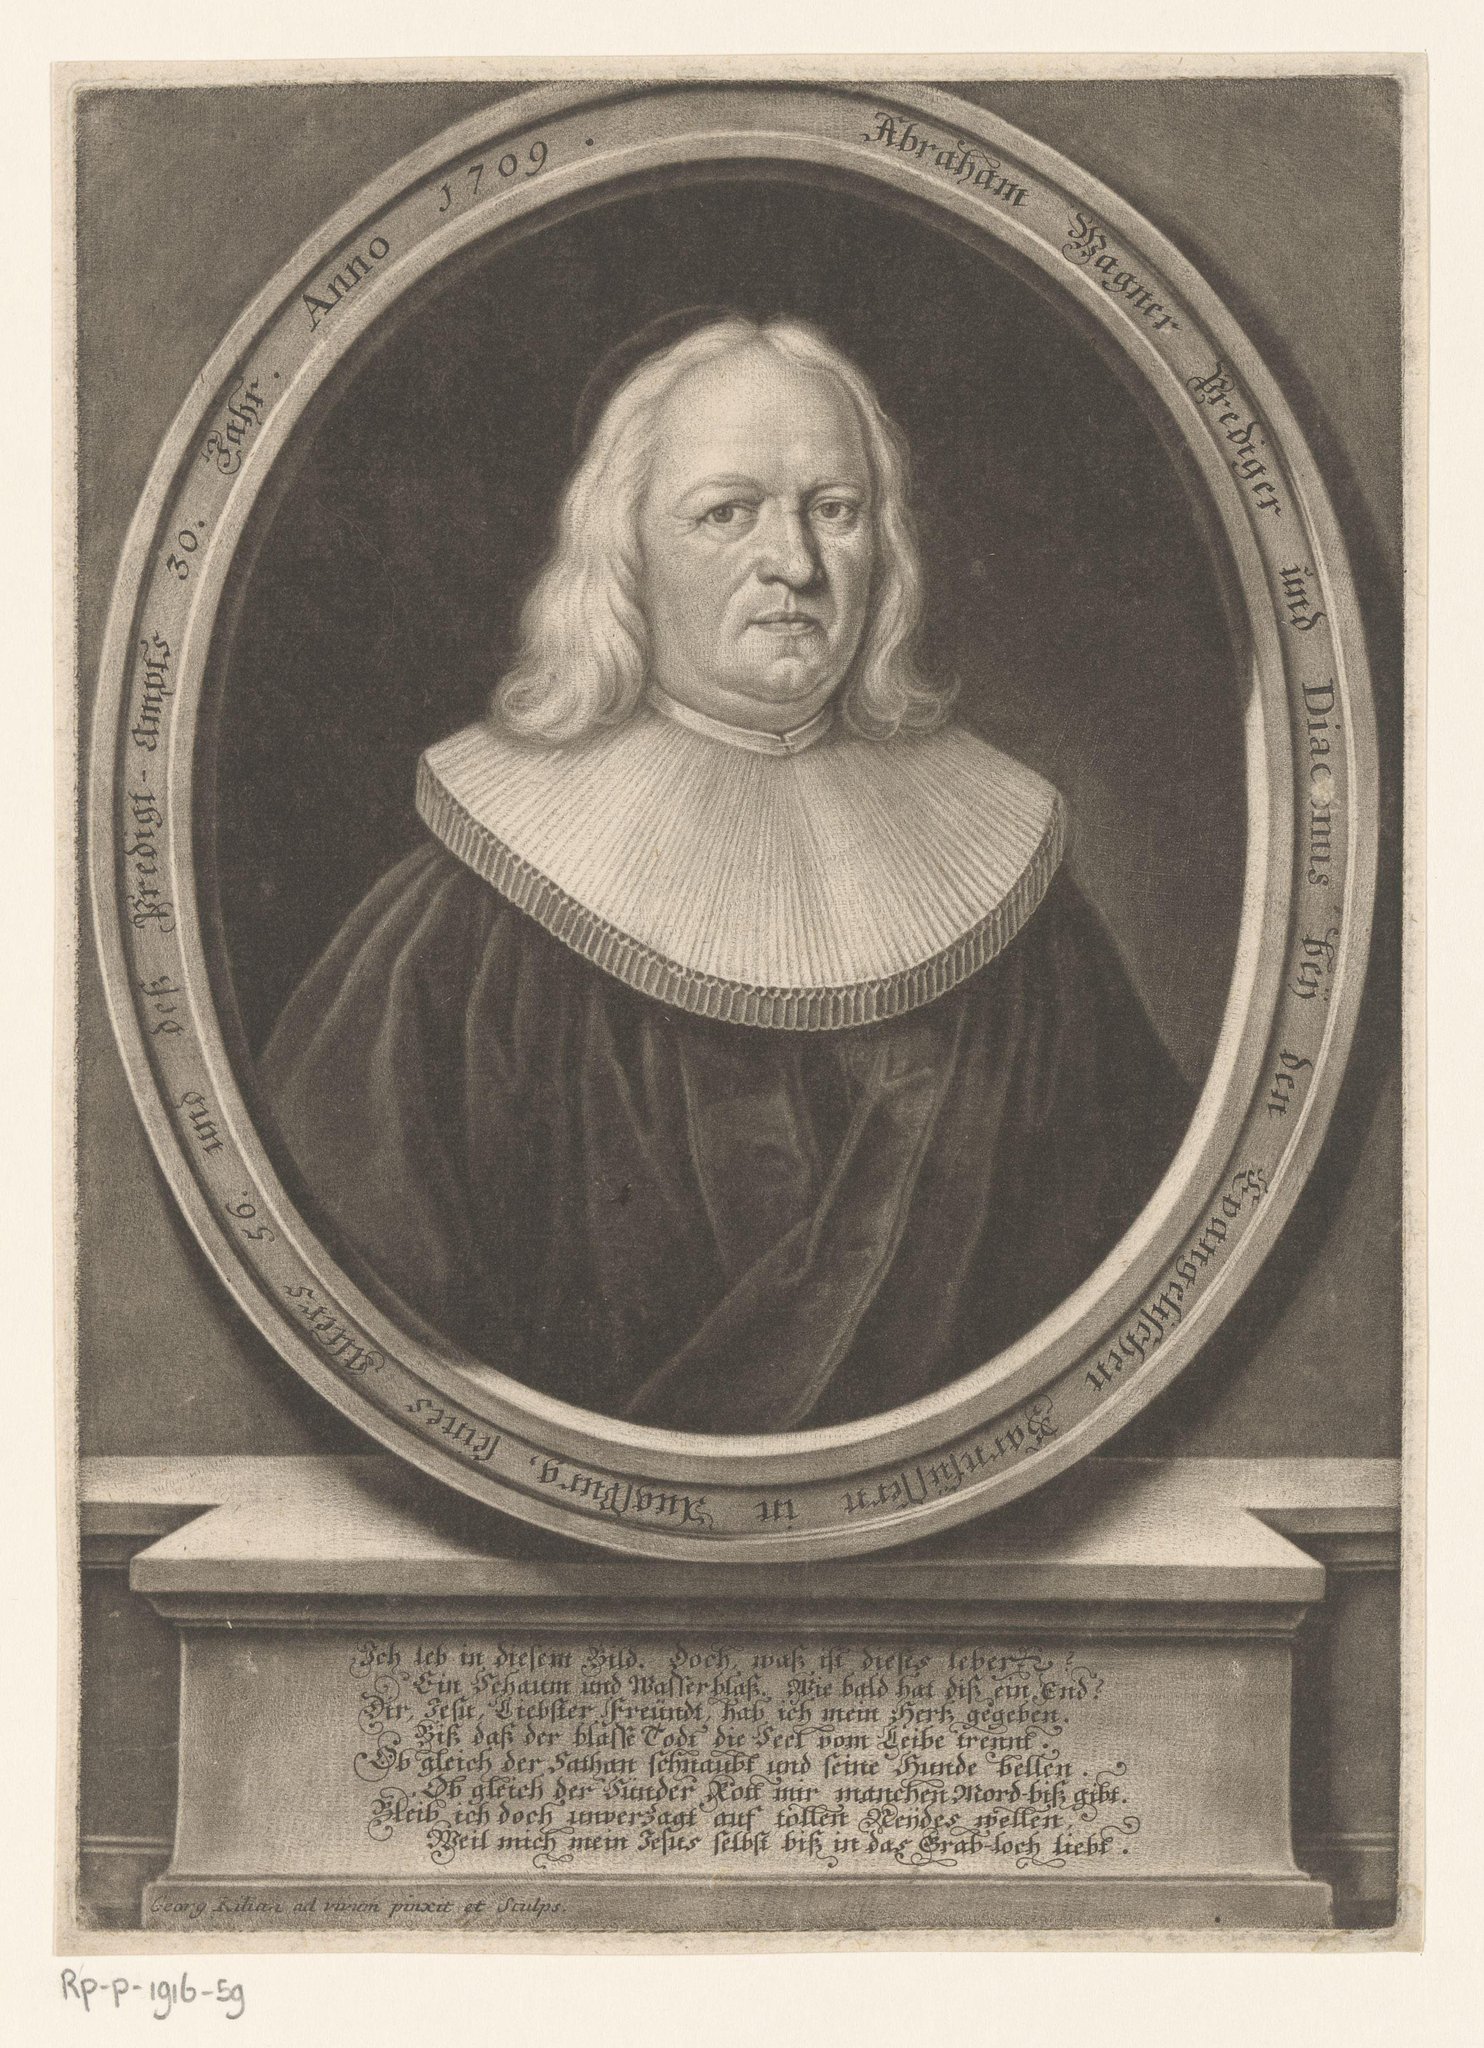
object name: print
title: Portret van Abraham Wagner op 56-jarige leeftijd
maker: georg kilian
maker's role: print maker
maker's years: 1683-1745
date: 1709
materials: paper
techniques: mezzotint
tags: abraham wagner (1653-1728), historical persons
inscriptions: collector's mark: Lugt 2228